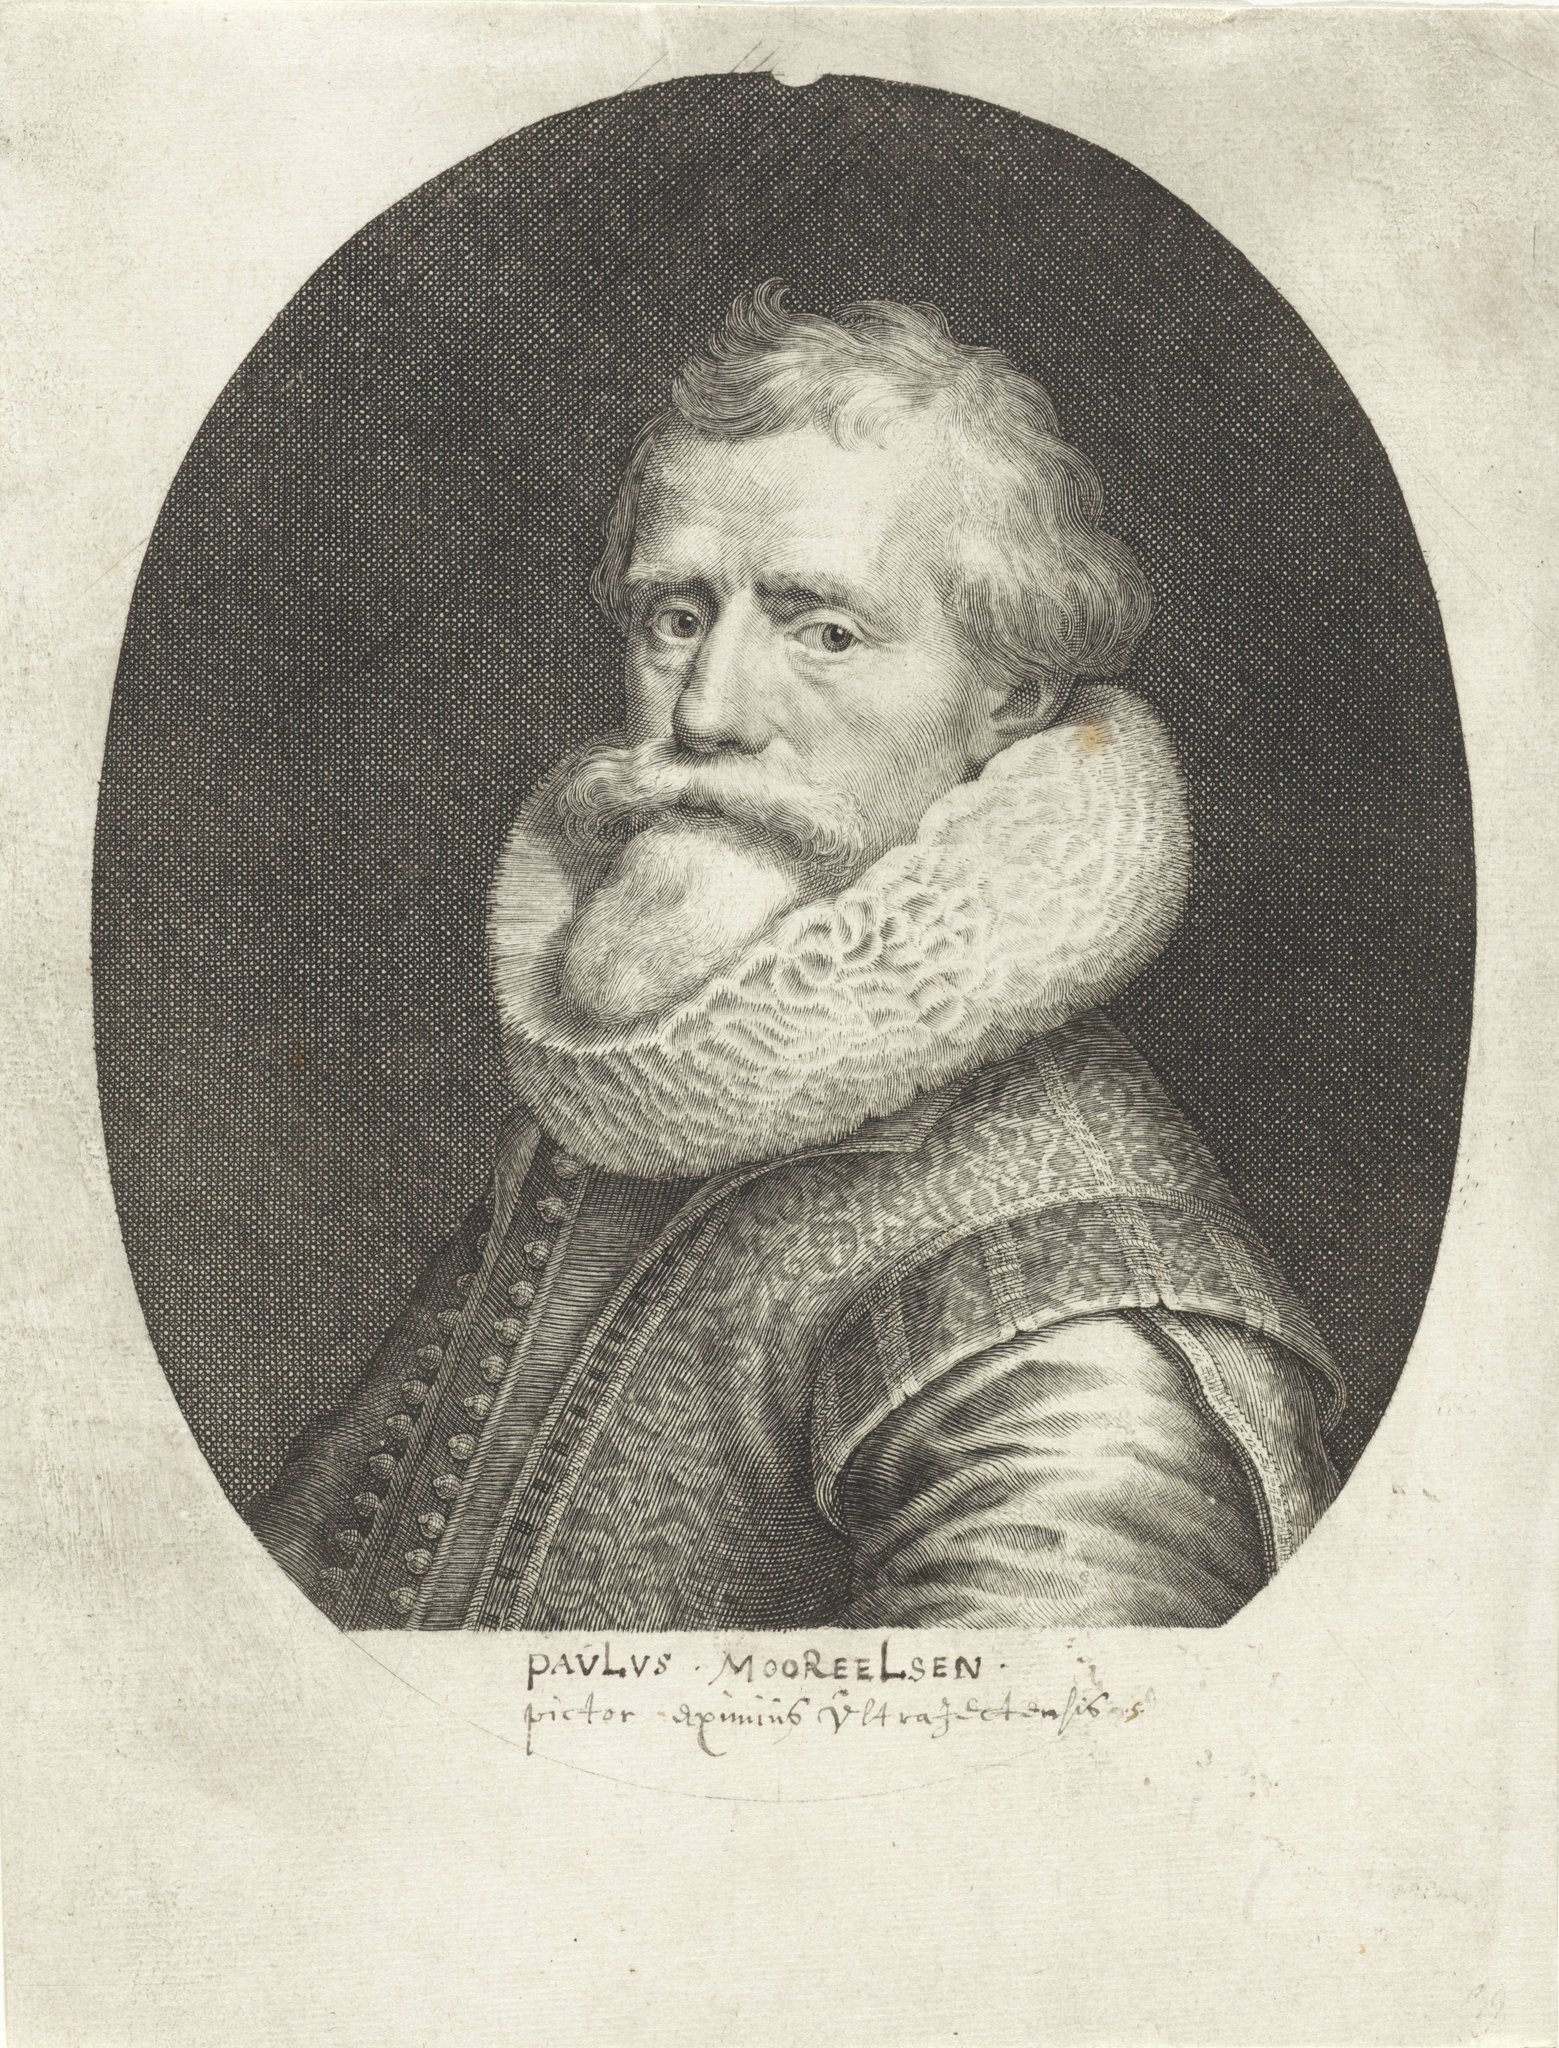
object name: print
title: Portret van Paulus Moreelse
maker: willem isaacsz. van swanenburg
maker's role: print maker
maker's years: 1580-1612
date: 1605-1612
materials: paper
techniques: engraving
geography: leiden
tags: utrecht, painter, print maker, draughtsman, paulus moreelse, portrait, self-portrait of painter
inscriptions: collector's mark: Lugt 2228, inscription: ‘Paulus . Mooreelsen . / pictor ...ius ultrajectensis’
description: Portret van de schilder Paulus Moreelse met baard en een brede kraag.